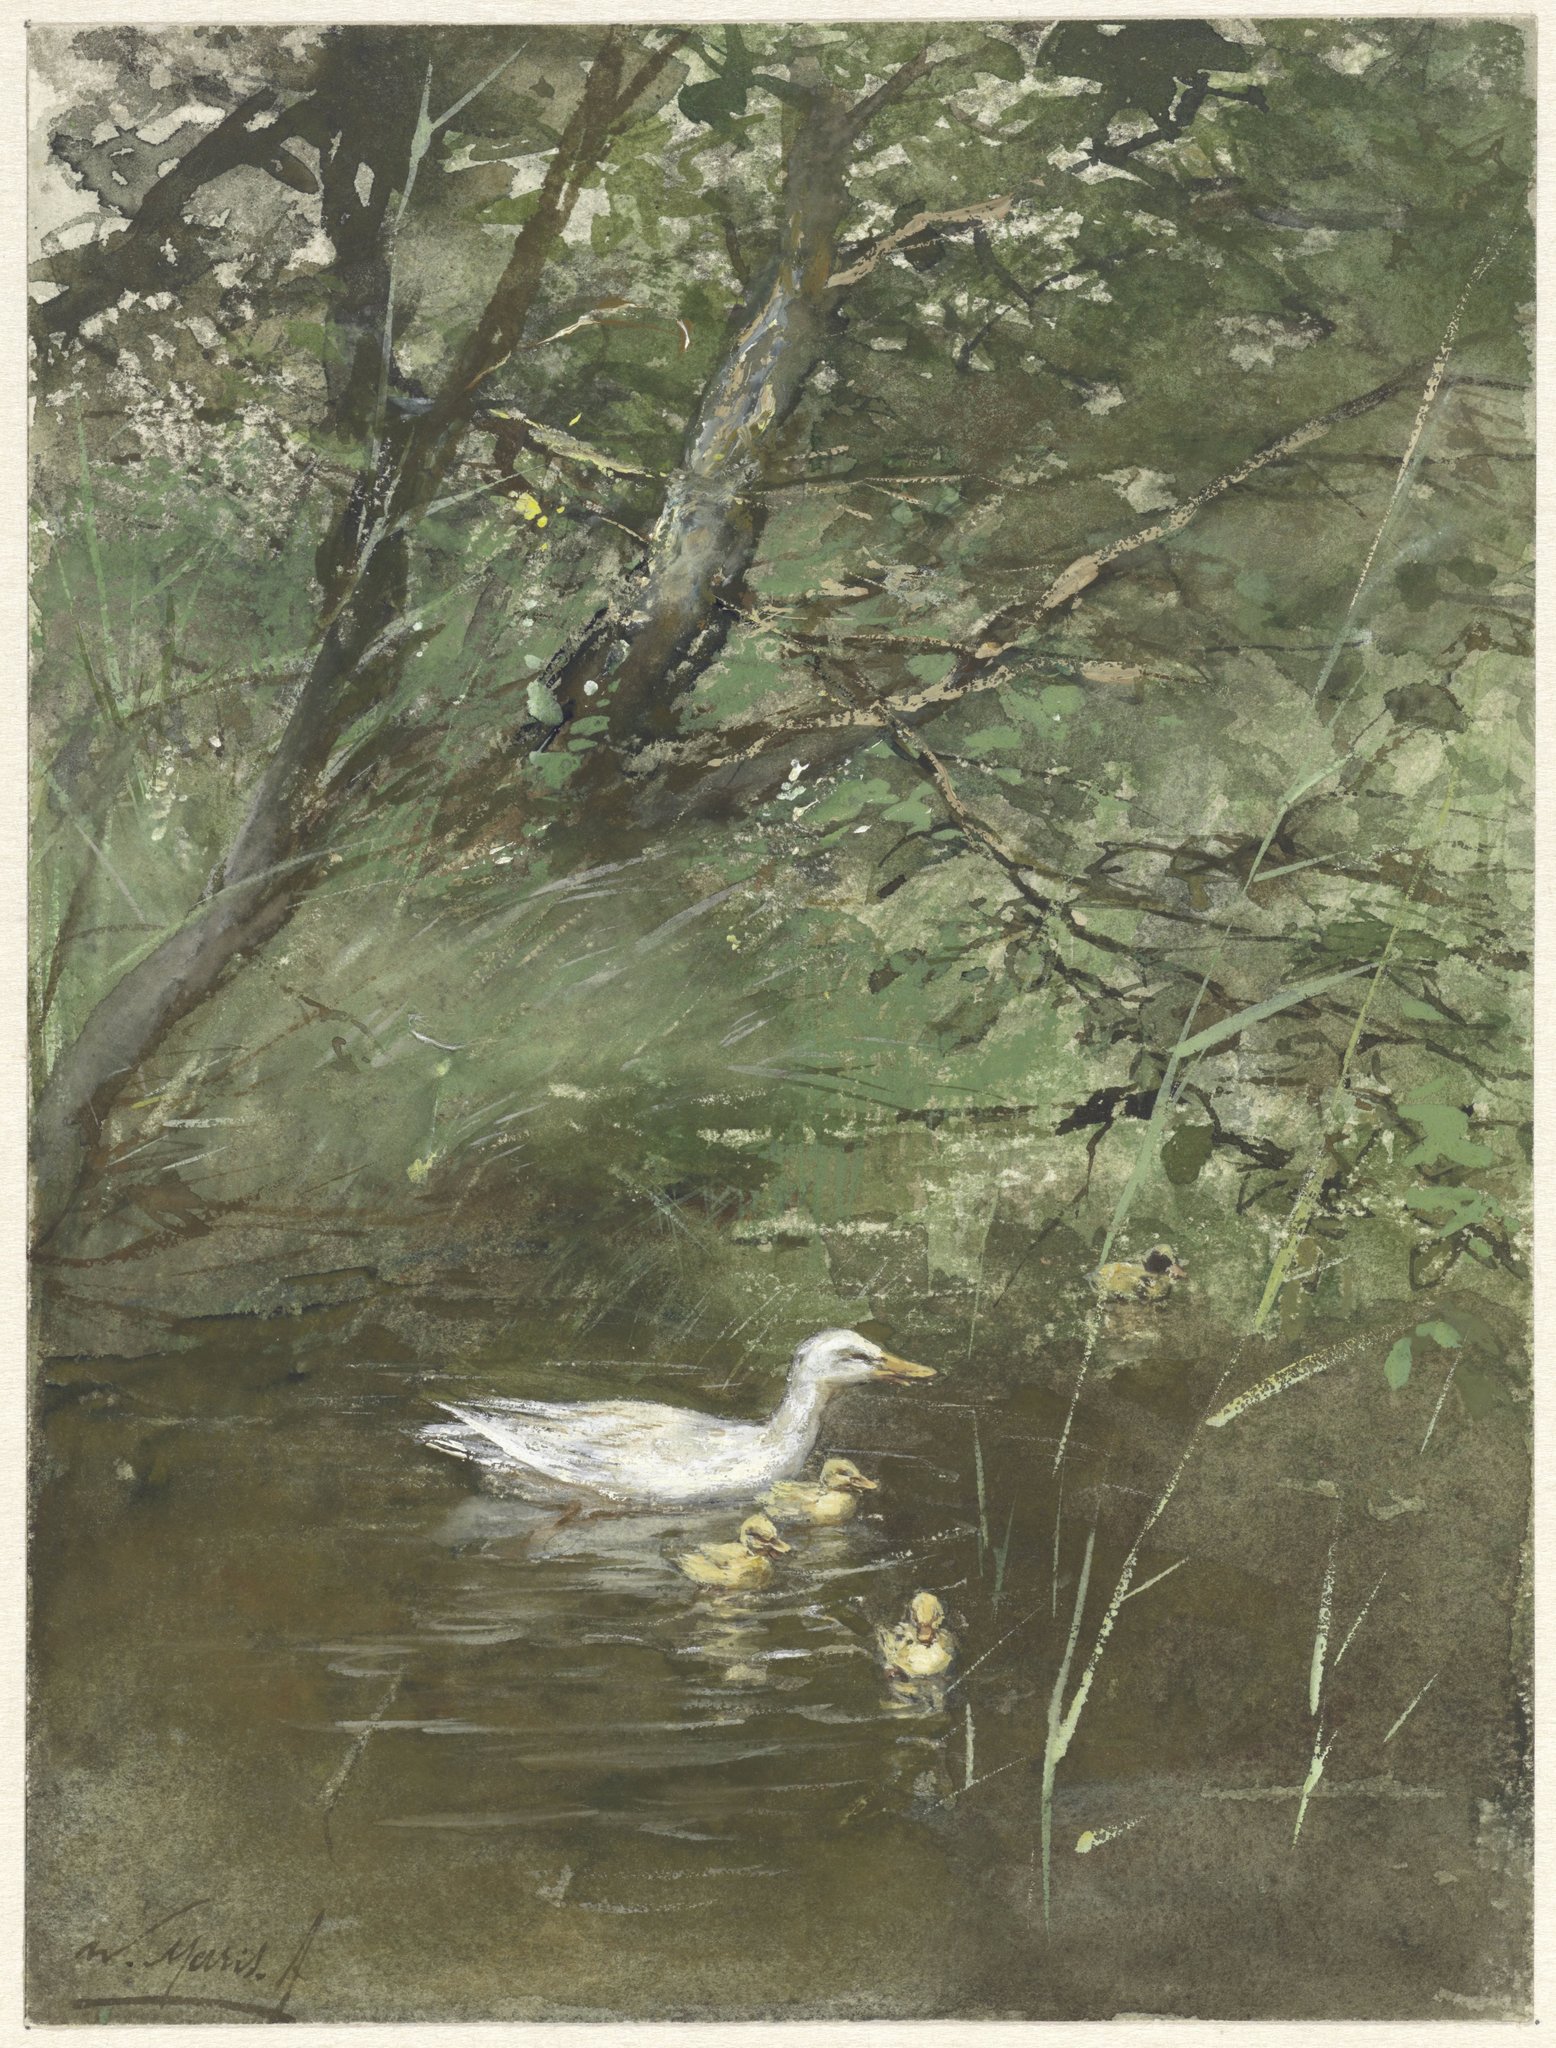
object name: drawing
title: Eendjes in het water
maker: willem maris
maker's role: draughtsman, painter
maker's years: 1844-1910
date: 1854-1892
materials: paper, watercolor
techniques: brush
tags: domestic waterbirds